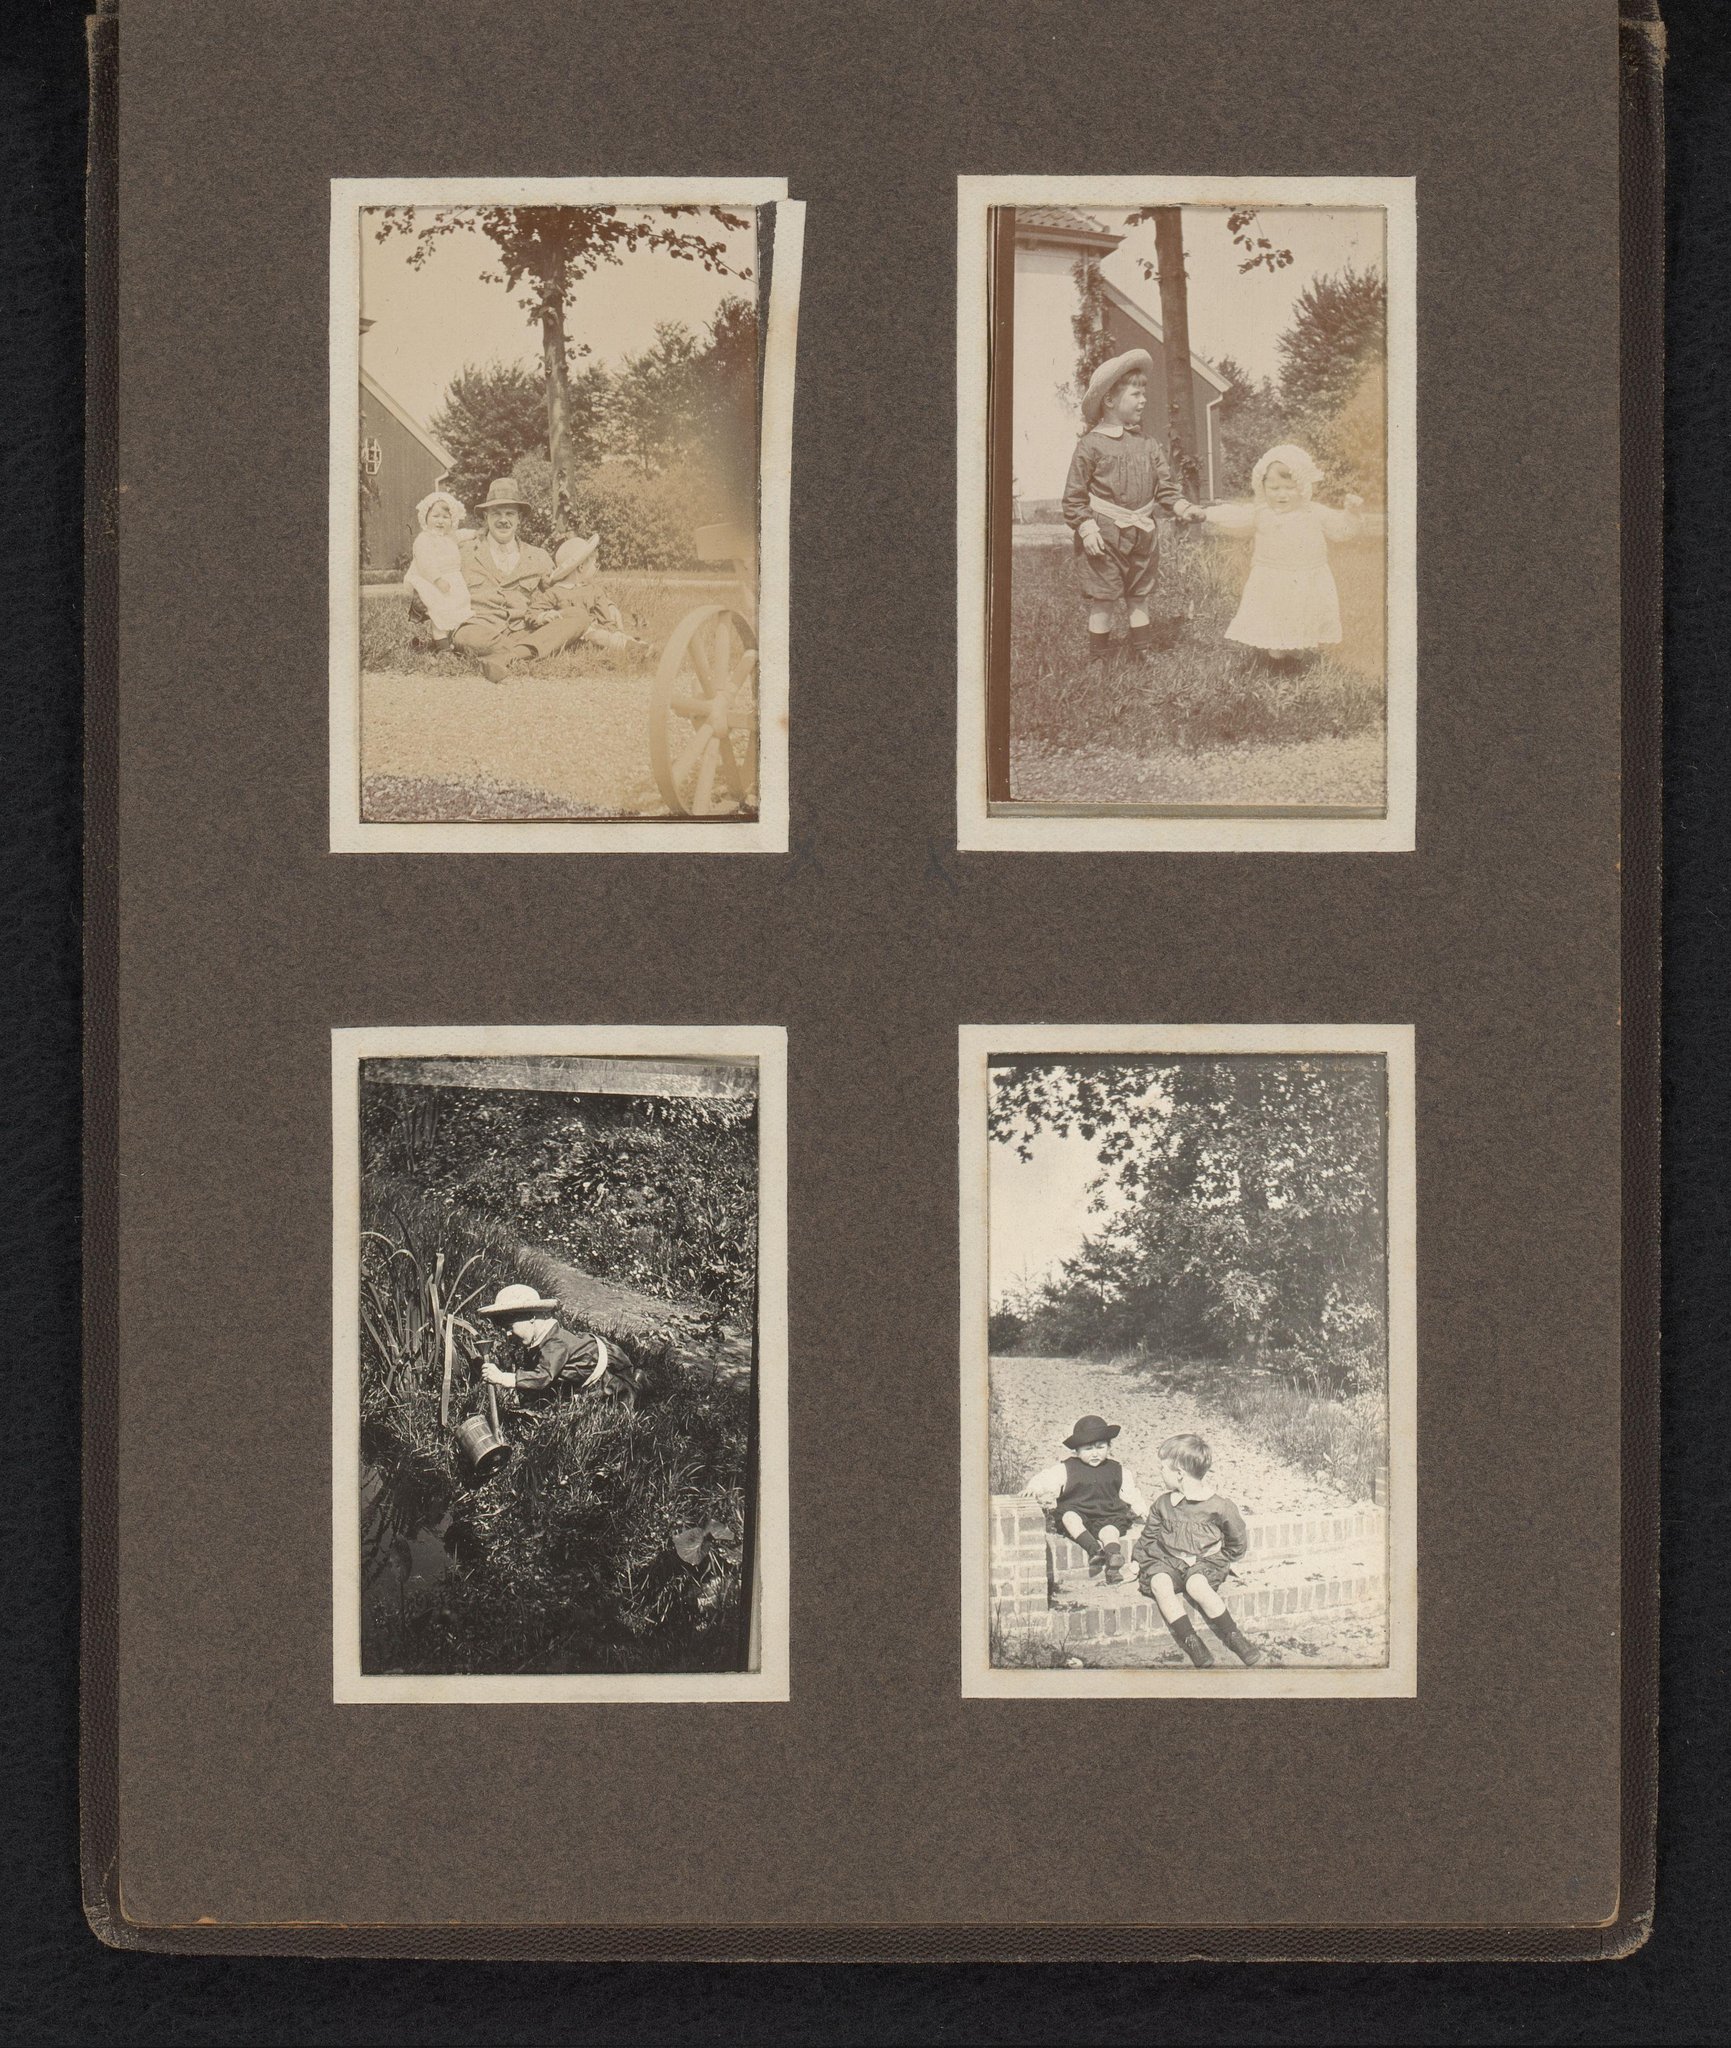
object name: photograph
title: Vier foto's van Carel Frederik en Frank Willem van den Berg in een tuin in Bergerac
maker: hendrik herman van den berg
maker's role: amateurfotograaf, jurist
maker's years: 1875-1944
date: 1914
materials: paper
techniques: gelatin silver print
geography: bergerac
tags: hendrik herman van den berg, carel frederik van den berg (cay), frank willem van den berg (1912-1998), garden, father and child(ren), man and child(ren) (family group)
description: Deze foto's maken deel uit van een album.